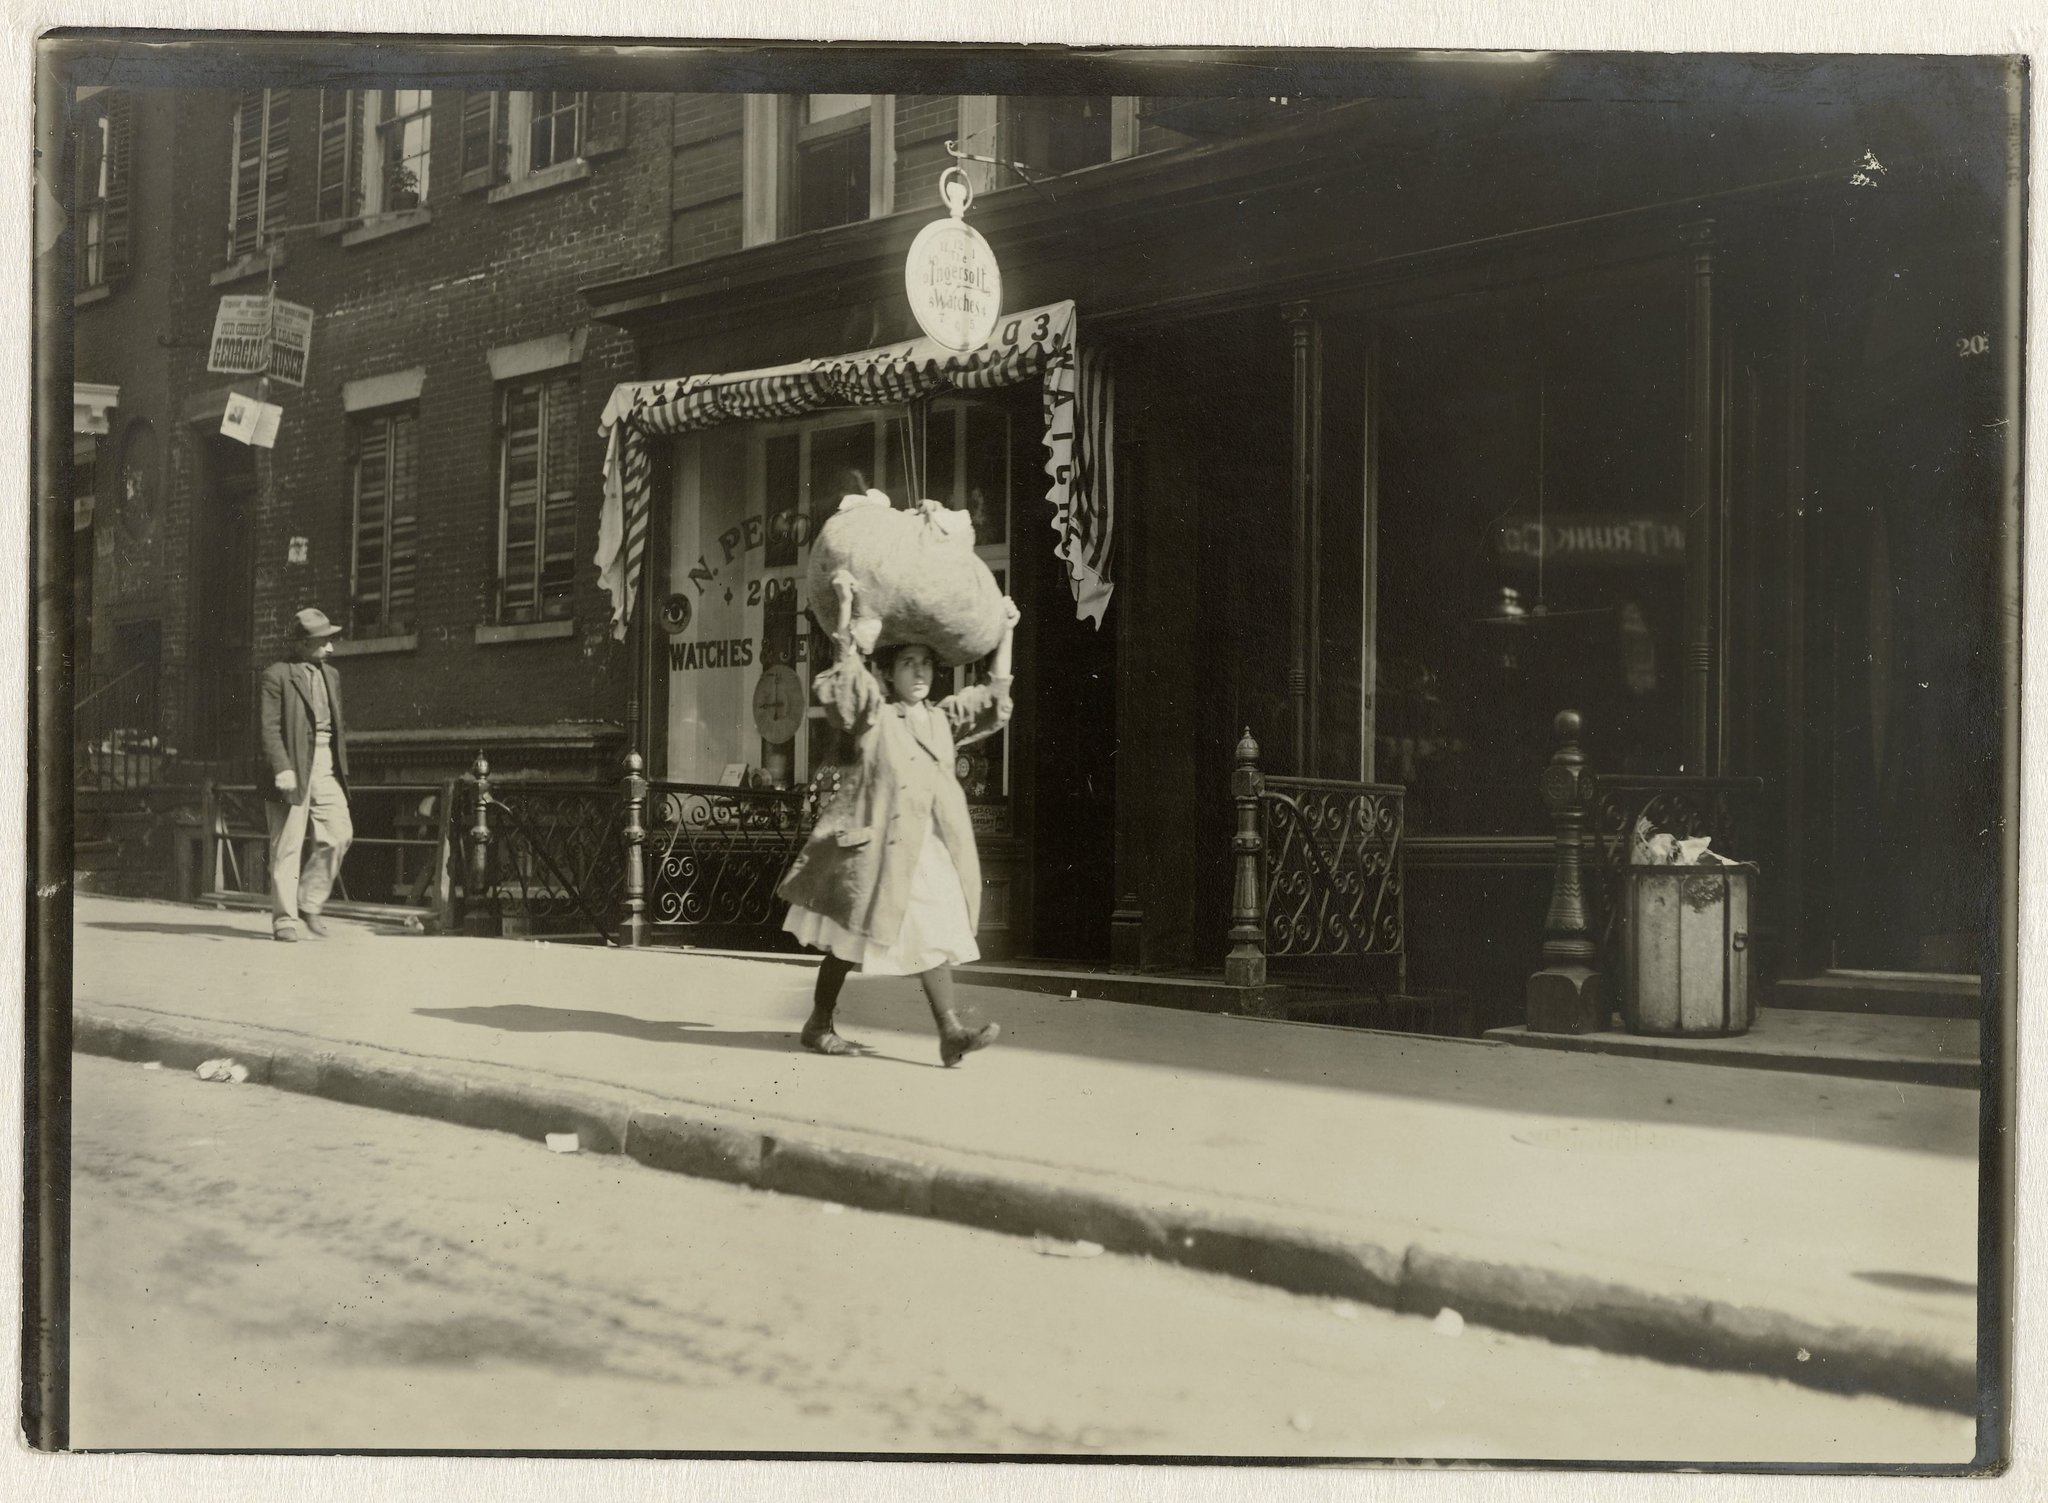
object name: photograph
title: Girl Carrying Homework thro Greenwich Village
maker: lewis wickes hine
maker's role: fotograaf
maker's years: 1874-1940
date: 1909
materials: paper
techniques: gelatin silver print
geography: new york city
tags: girl (child between toddler and youth), new york (city)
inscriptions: inscription: ‘LEWIS W. HINE/ INTERPRETIVE PHOTOGRAPHY/ HASTINGS-ON-HUDSON, NEW YORK’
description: American photographer Lewis Hine is known primarily for his investigative photographs of child labour, which he took for the National Child Labor Committee from 1908. He recorded how young children were exploited in factories, mines, and in fields and on the street. Hine’s photographs are a classic example of how photography contributed to social reform.